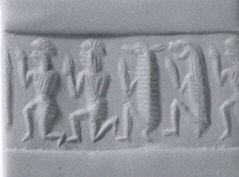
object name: cylinder seal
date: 1900-1701 BCE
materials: stone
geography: northern syria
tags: animals